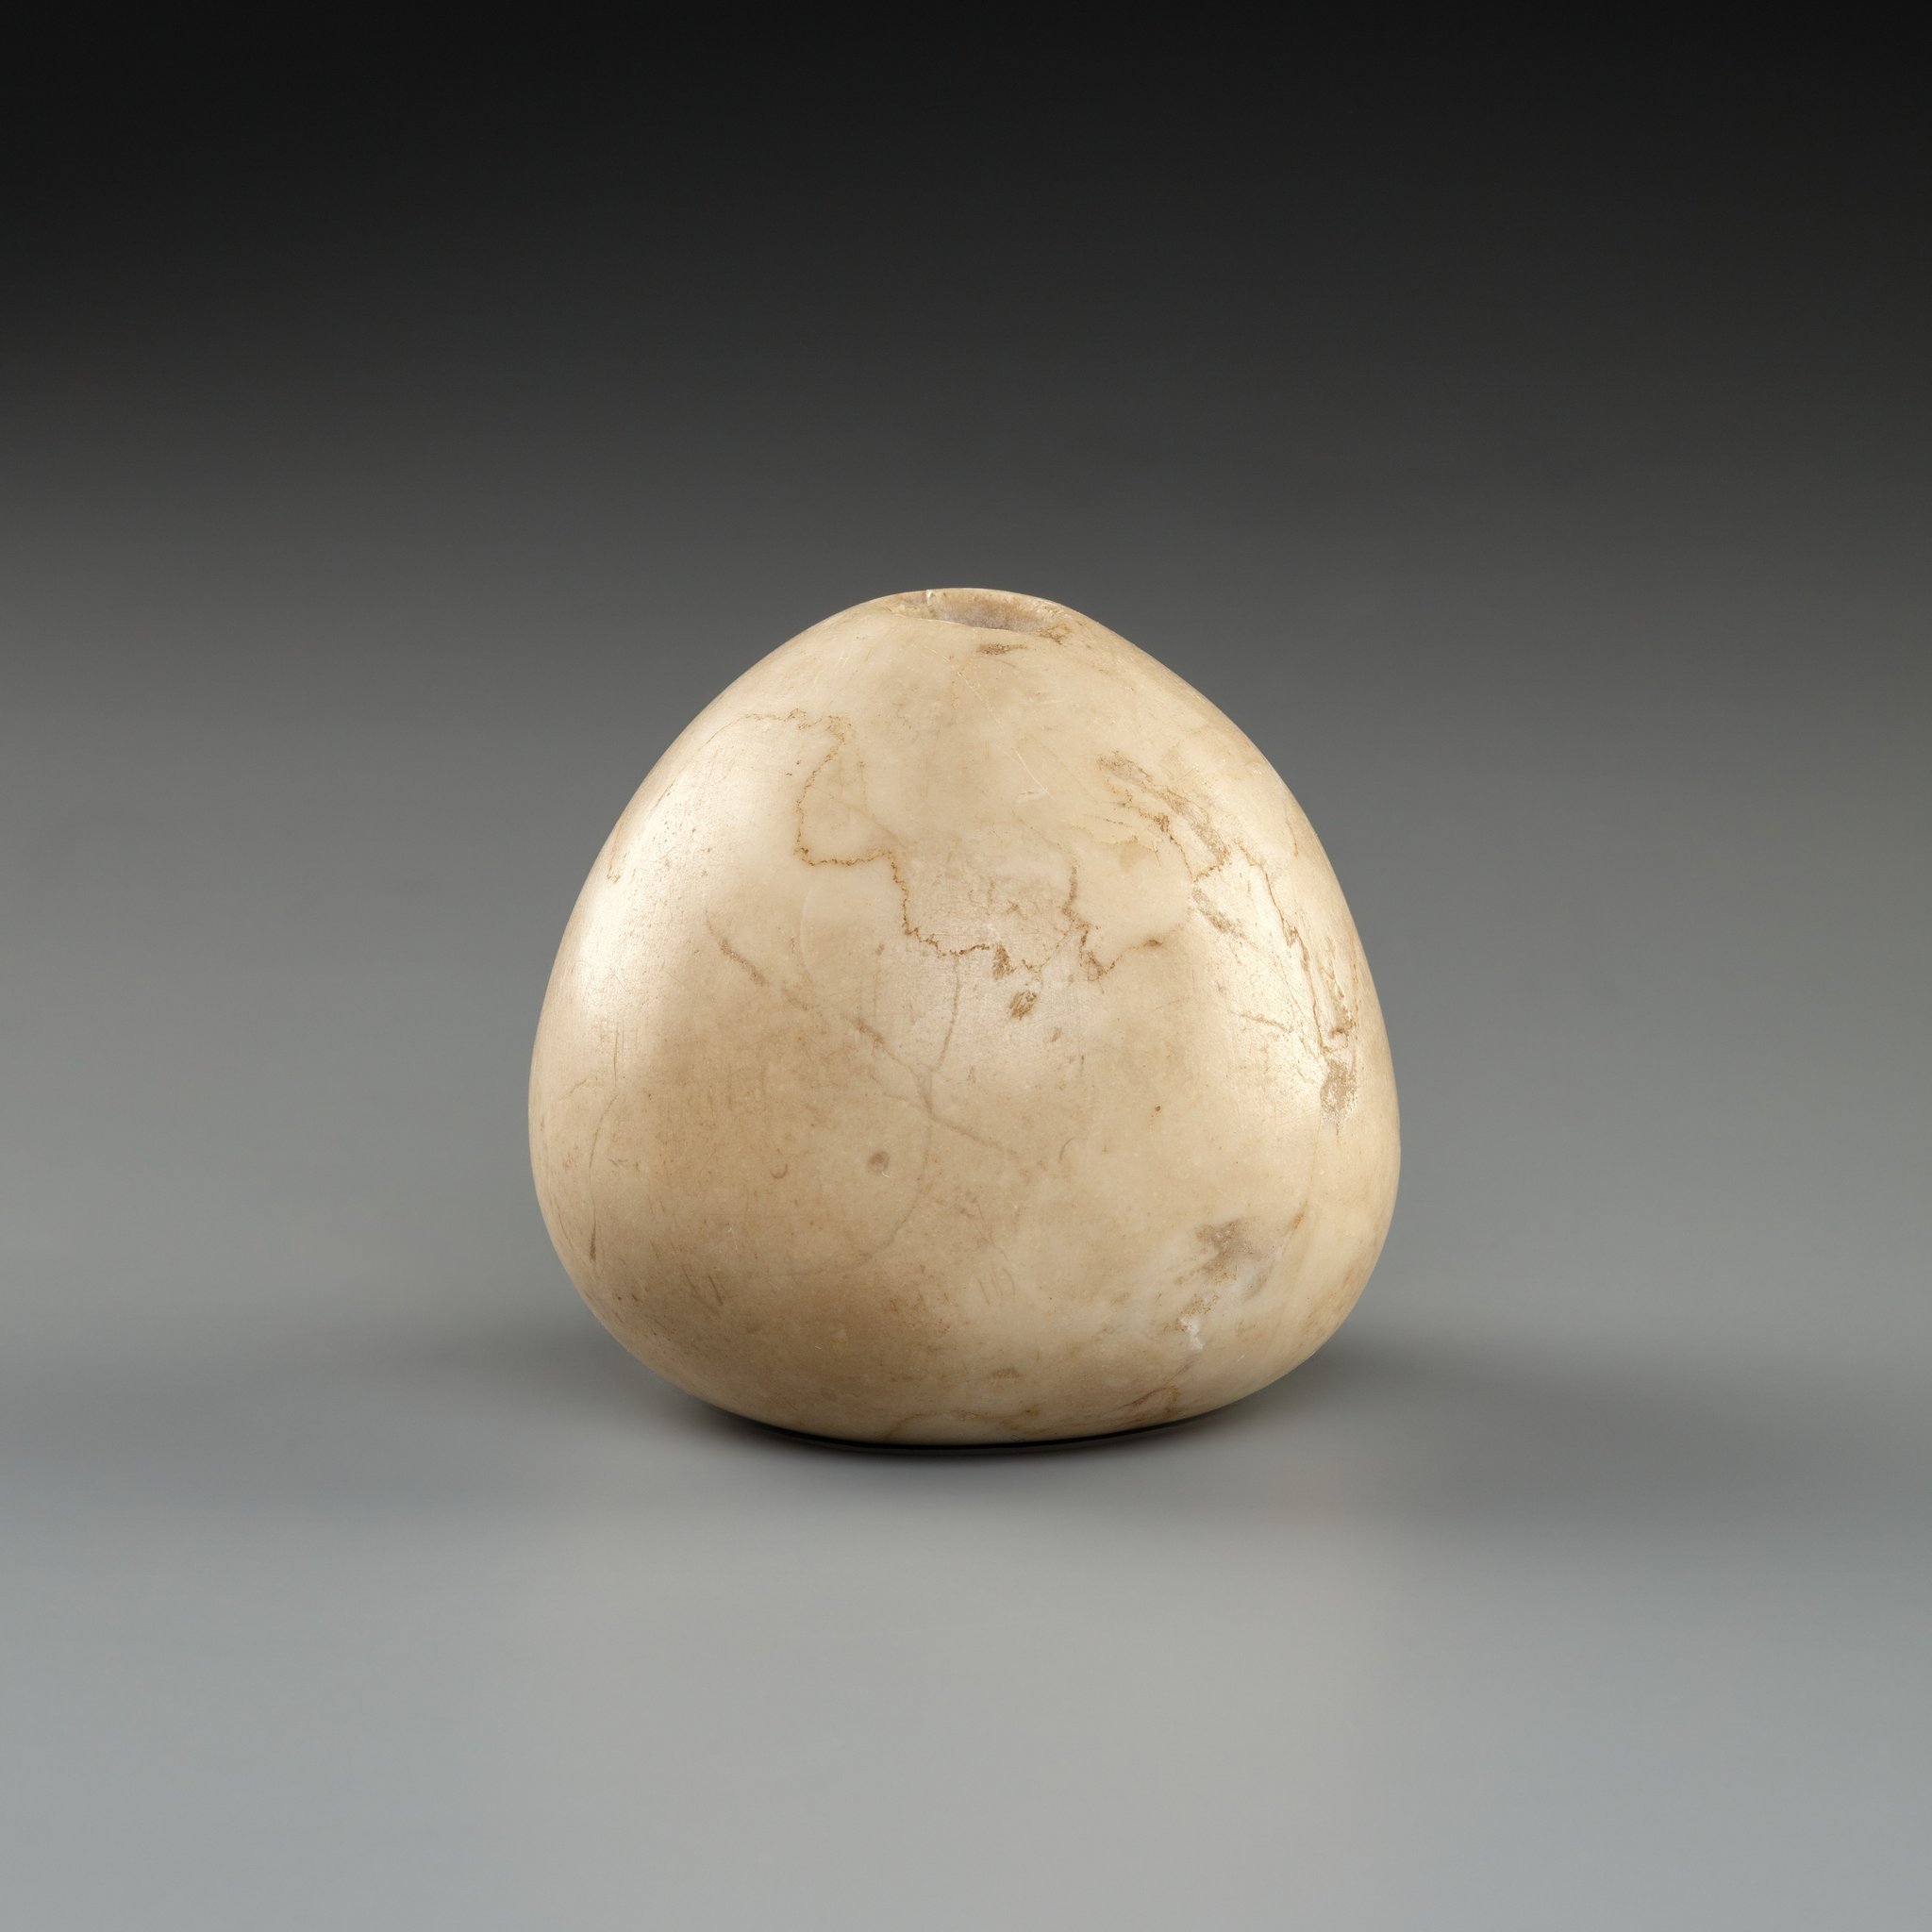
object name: mace head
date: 3850-2960 BCE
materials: limestone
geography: egypt